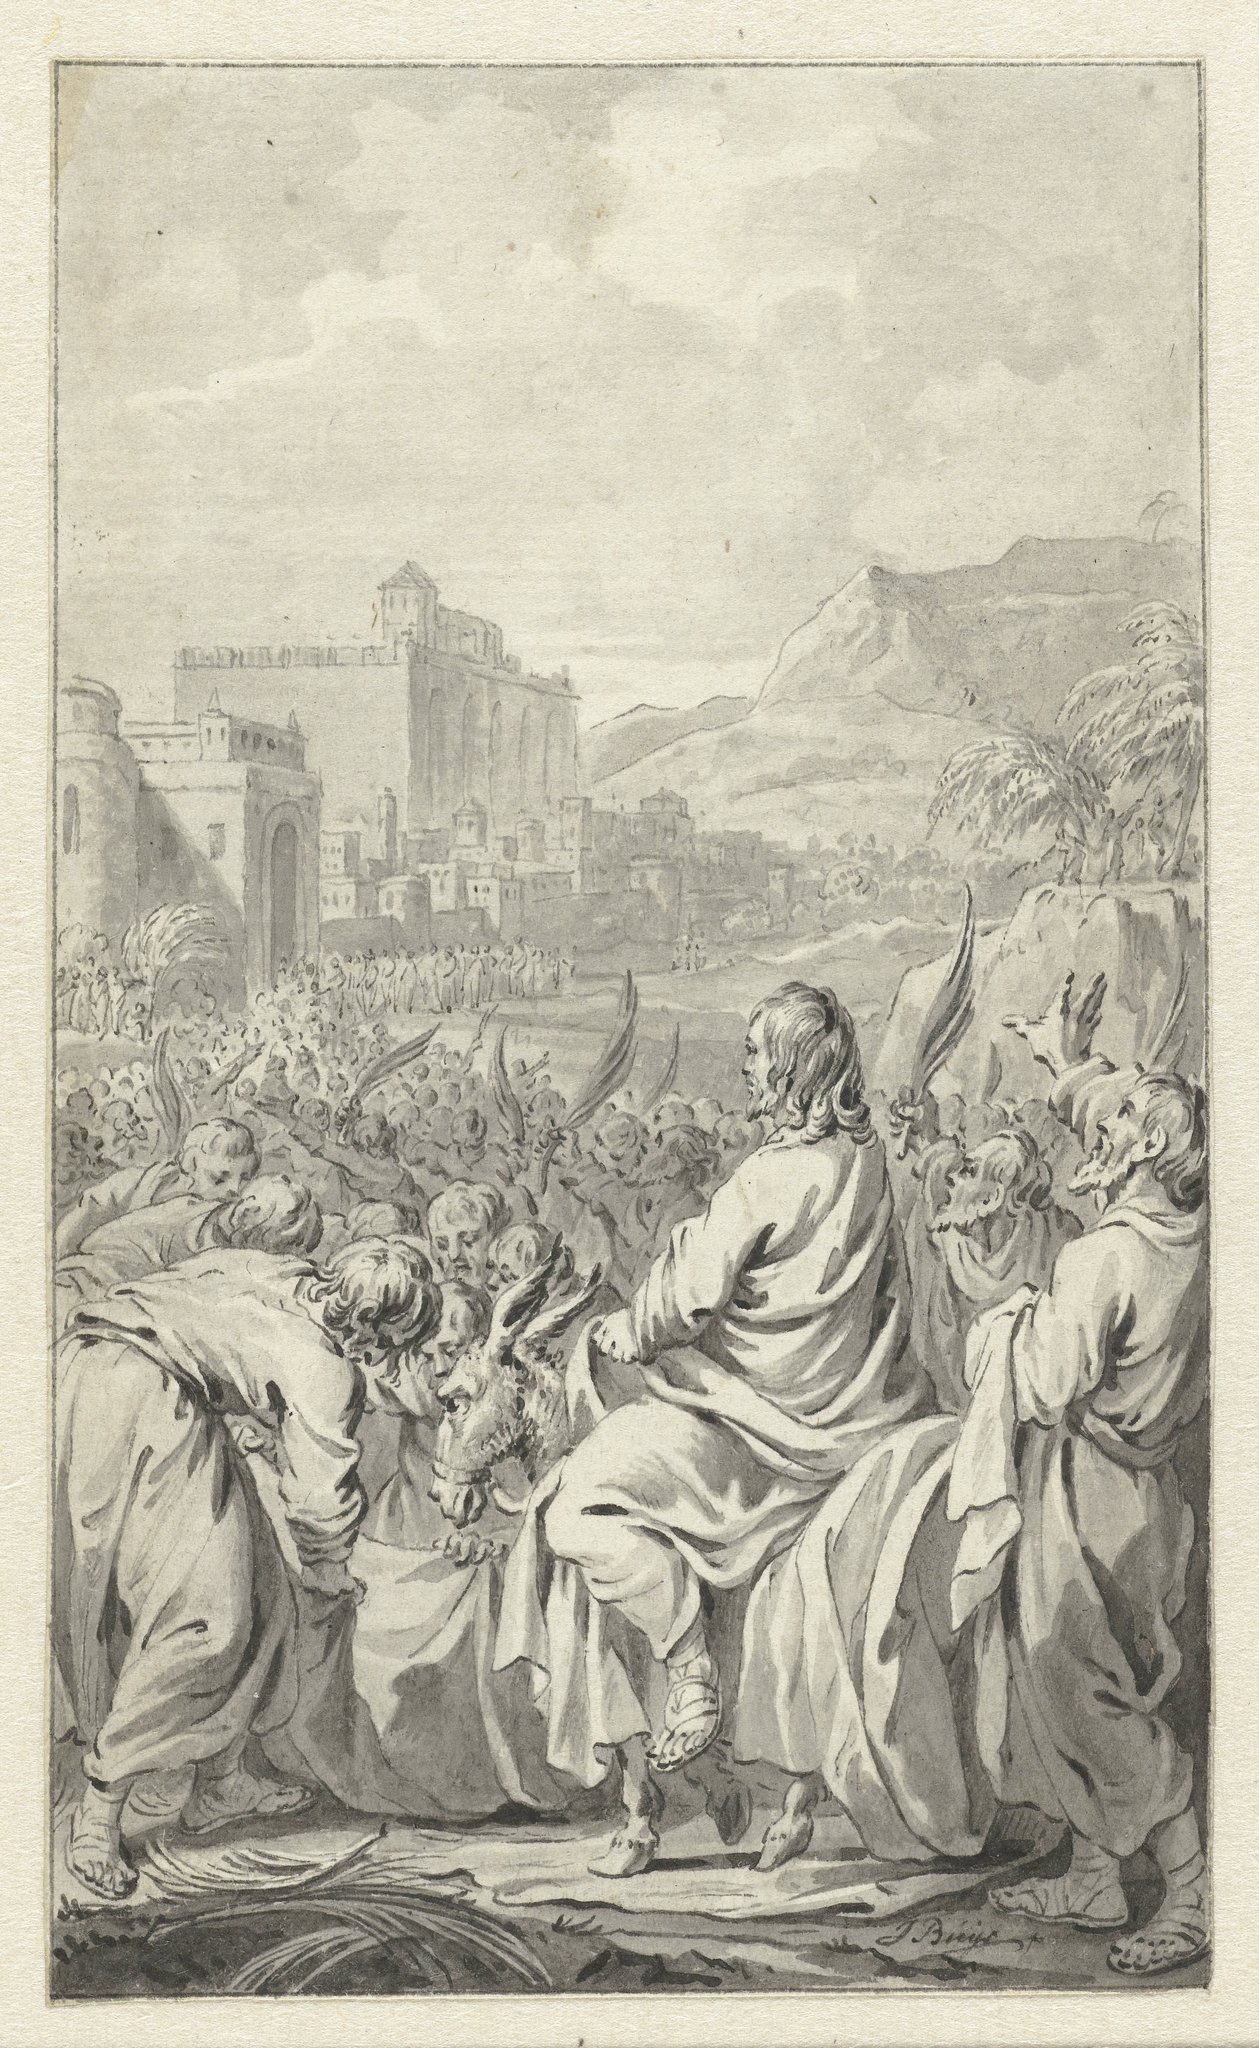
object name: drawing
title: De intocht in Jerusalem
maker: jacobus buys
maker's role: draughtsman, print maker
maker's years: 1724-1801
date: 1734-1801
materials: ink, paper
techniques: brush, pen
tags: entry into jerusalem: people spreading their clothes before christ on the ass, and waving palm branches (matthew 21:1-11, 21:14-16; mark 11:1-11; luke 19:28-40; john 12:12-19)